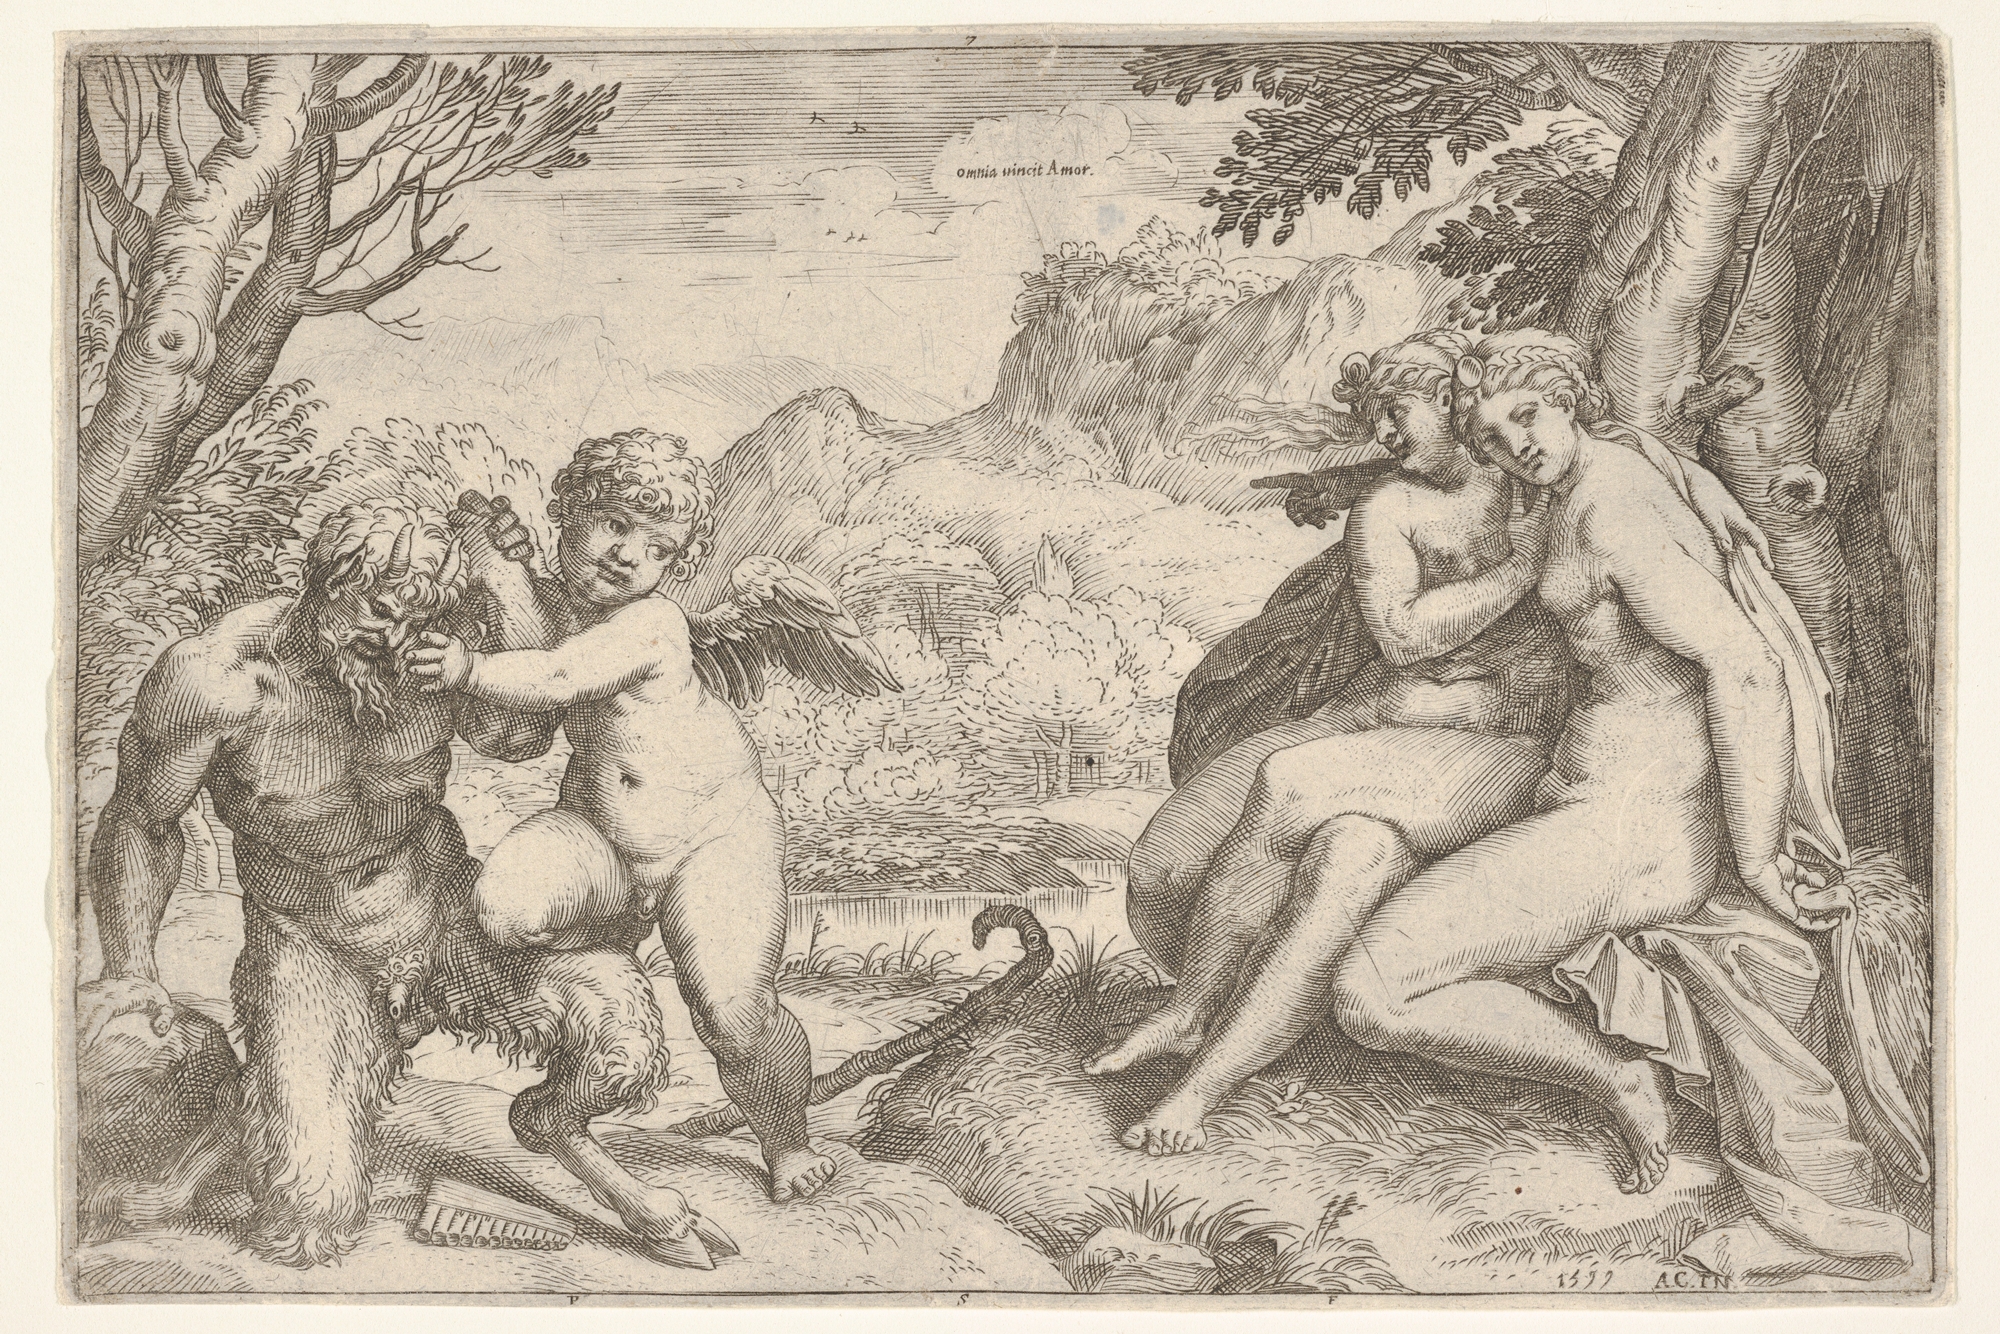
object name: print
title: Love Conquers All (Omnia vincit Amor), in a struggle with a satyr Amor places his right knee on its thigh, two nude nymphs are seated with interlocking legs at the base of a tree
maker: agostino carracci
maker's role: artist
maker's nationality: italian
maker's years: 1557-1602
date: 1599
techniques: engraving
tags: cupid,nymphs,satyrs